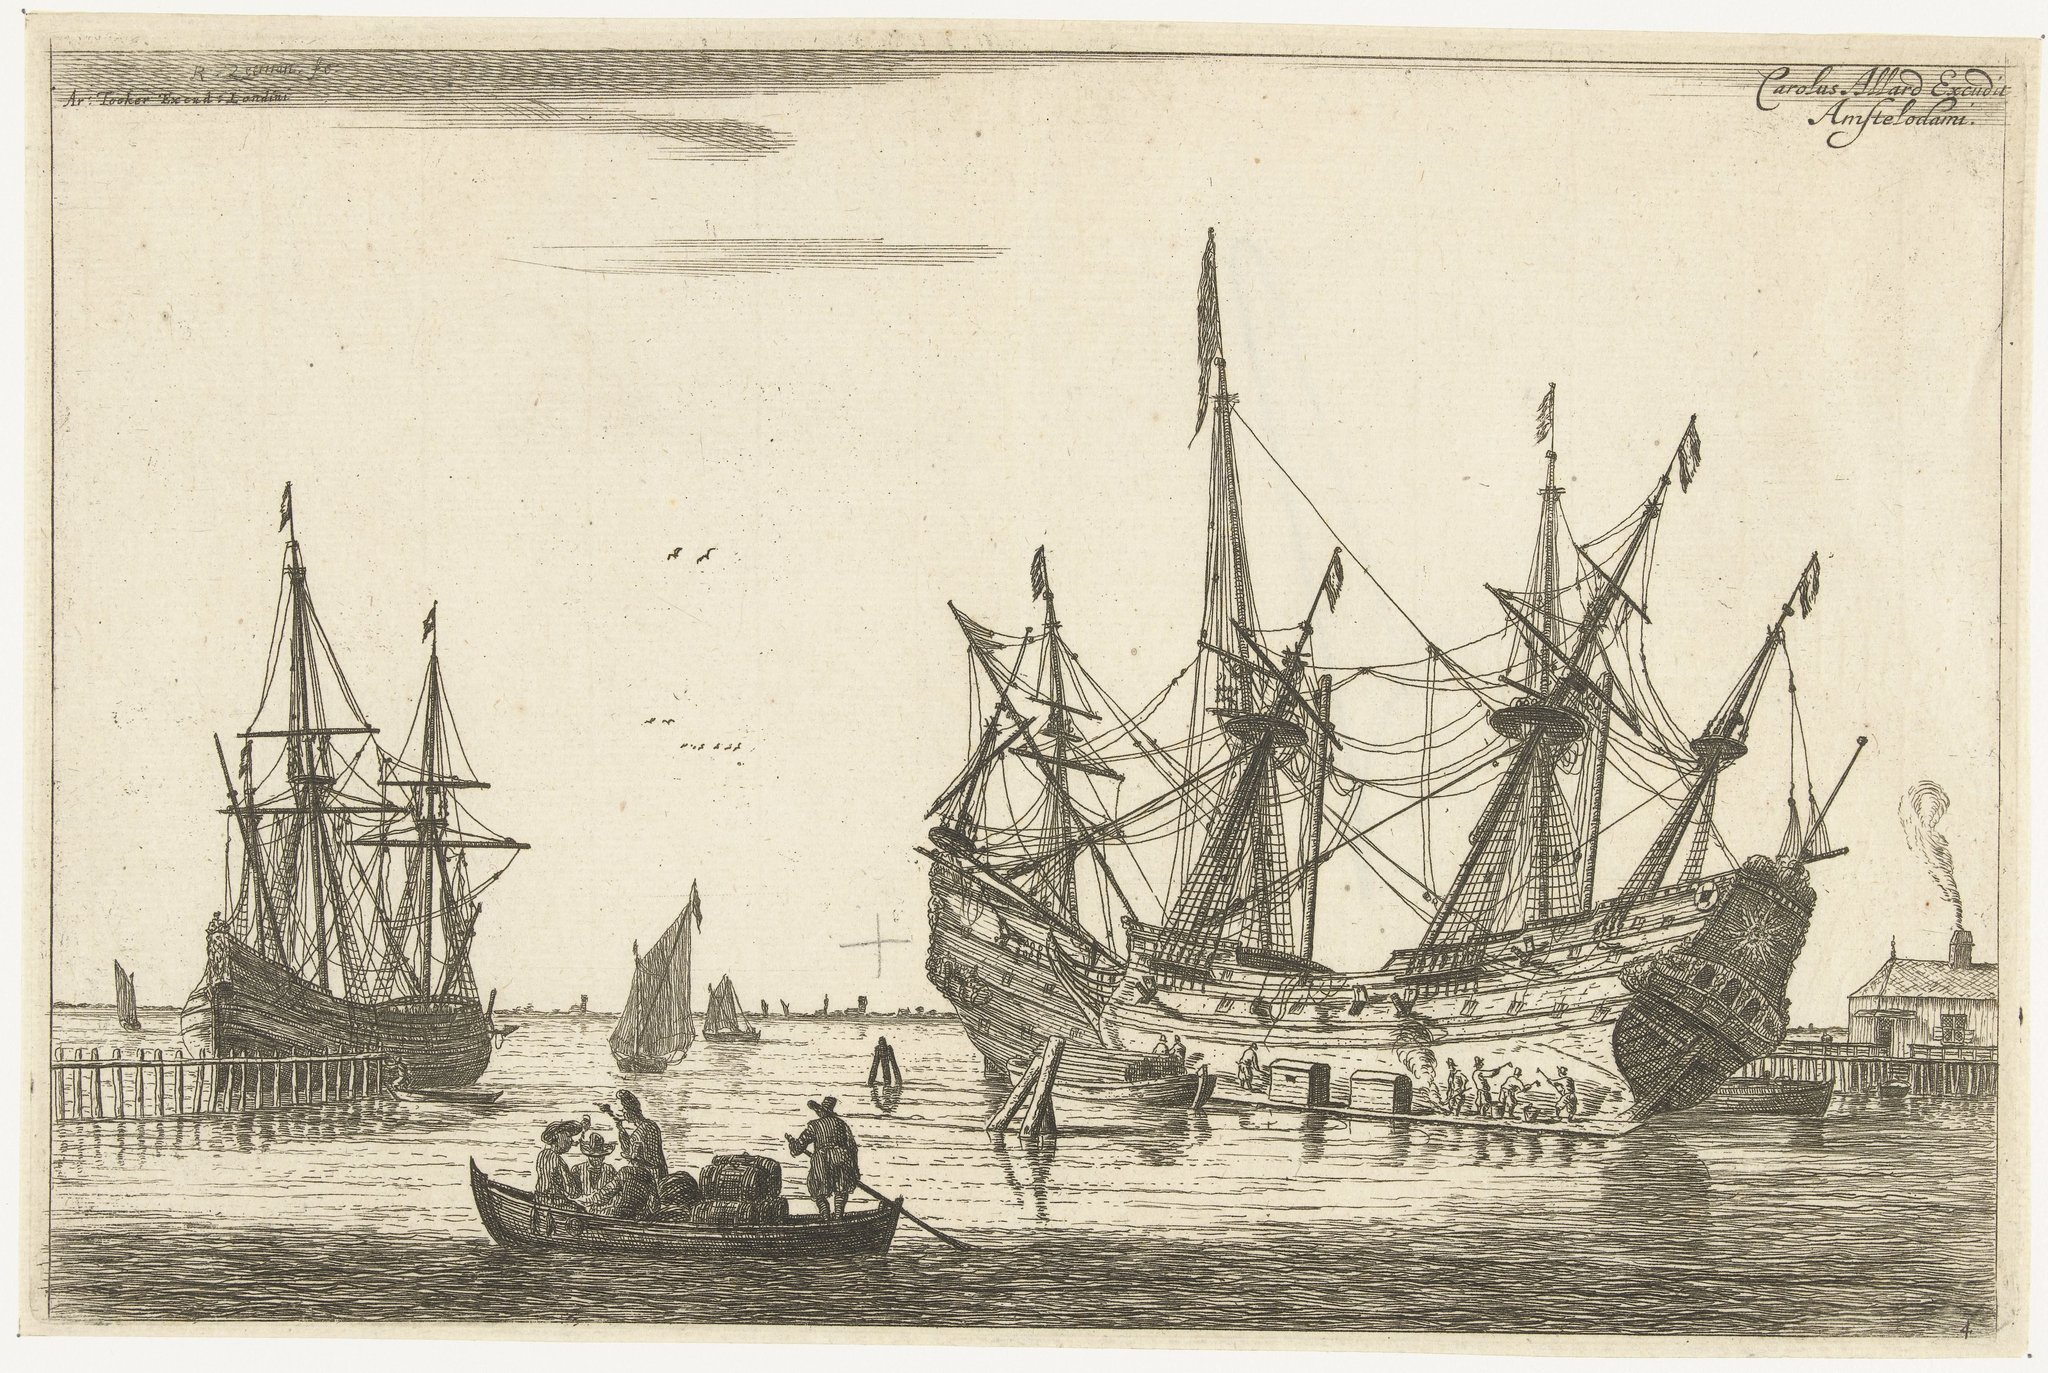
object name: print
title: Waterdichtmaken van de romp van een schip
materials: paper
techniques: etching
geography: amsterdam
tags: repairing, caulking, careening (~ ship)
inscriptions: collector's mark: Lugt 2228a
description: Een groot zeilschip ligt gekield in een werf. Mannen op een vlot werken aan de romp van het schip. In de haven nog een tweede zeilschip, een roeiboot met passagiers en een fluitschip bij een golfbreker.